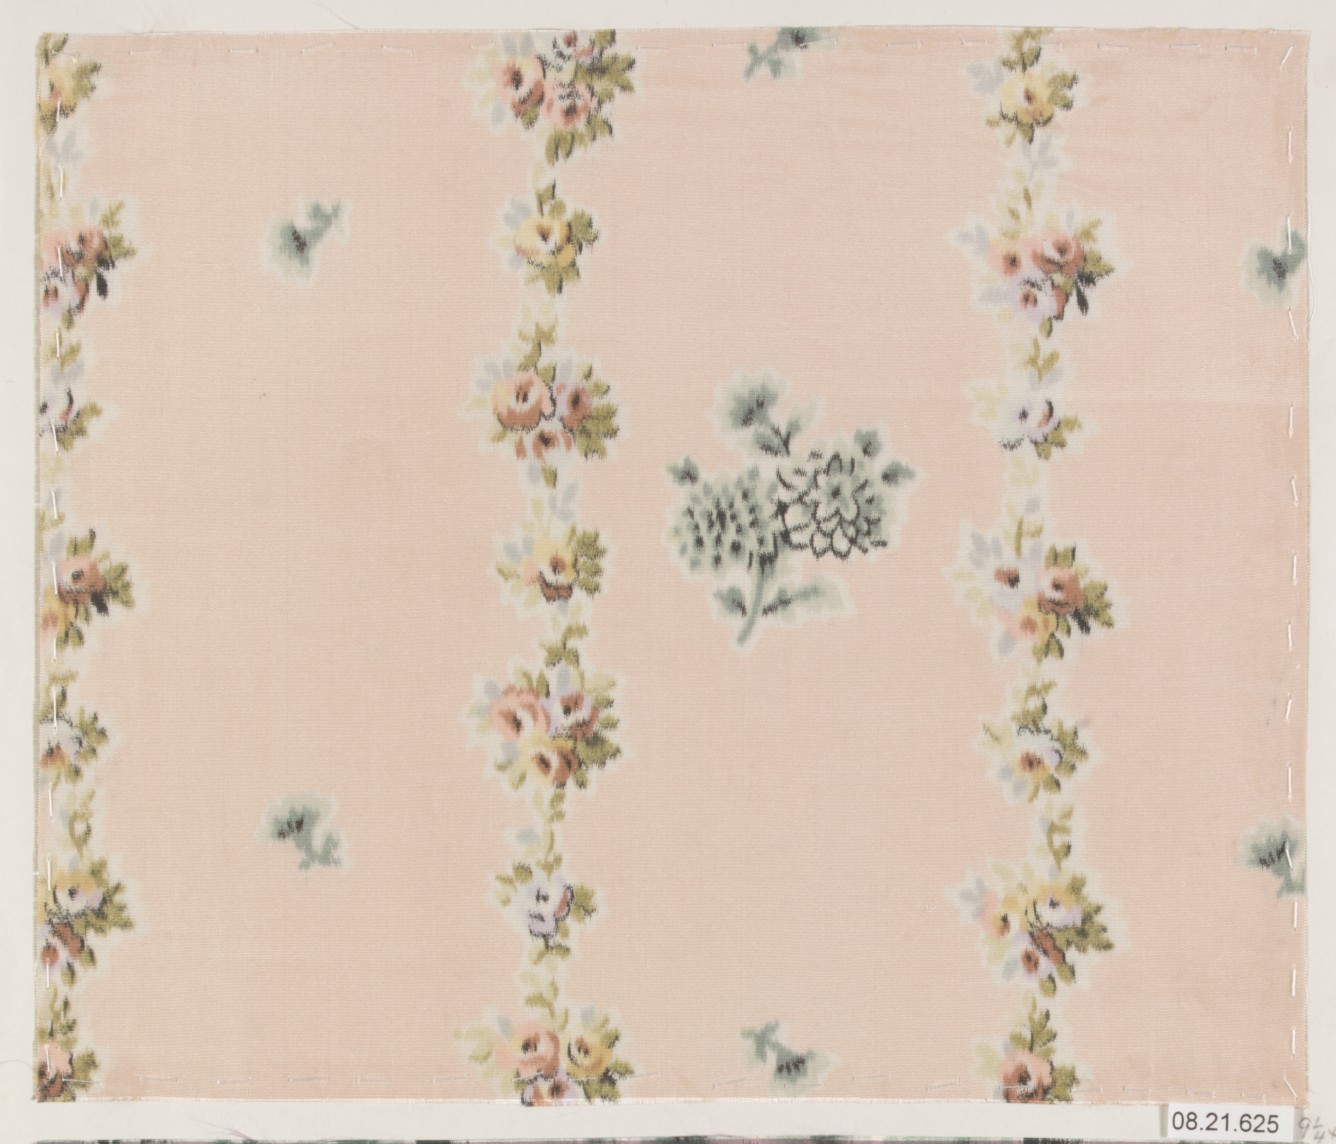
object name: textile sample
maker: Anonymous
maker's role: designer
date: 1900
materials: silk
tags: flowers